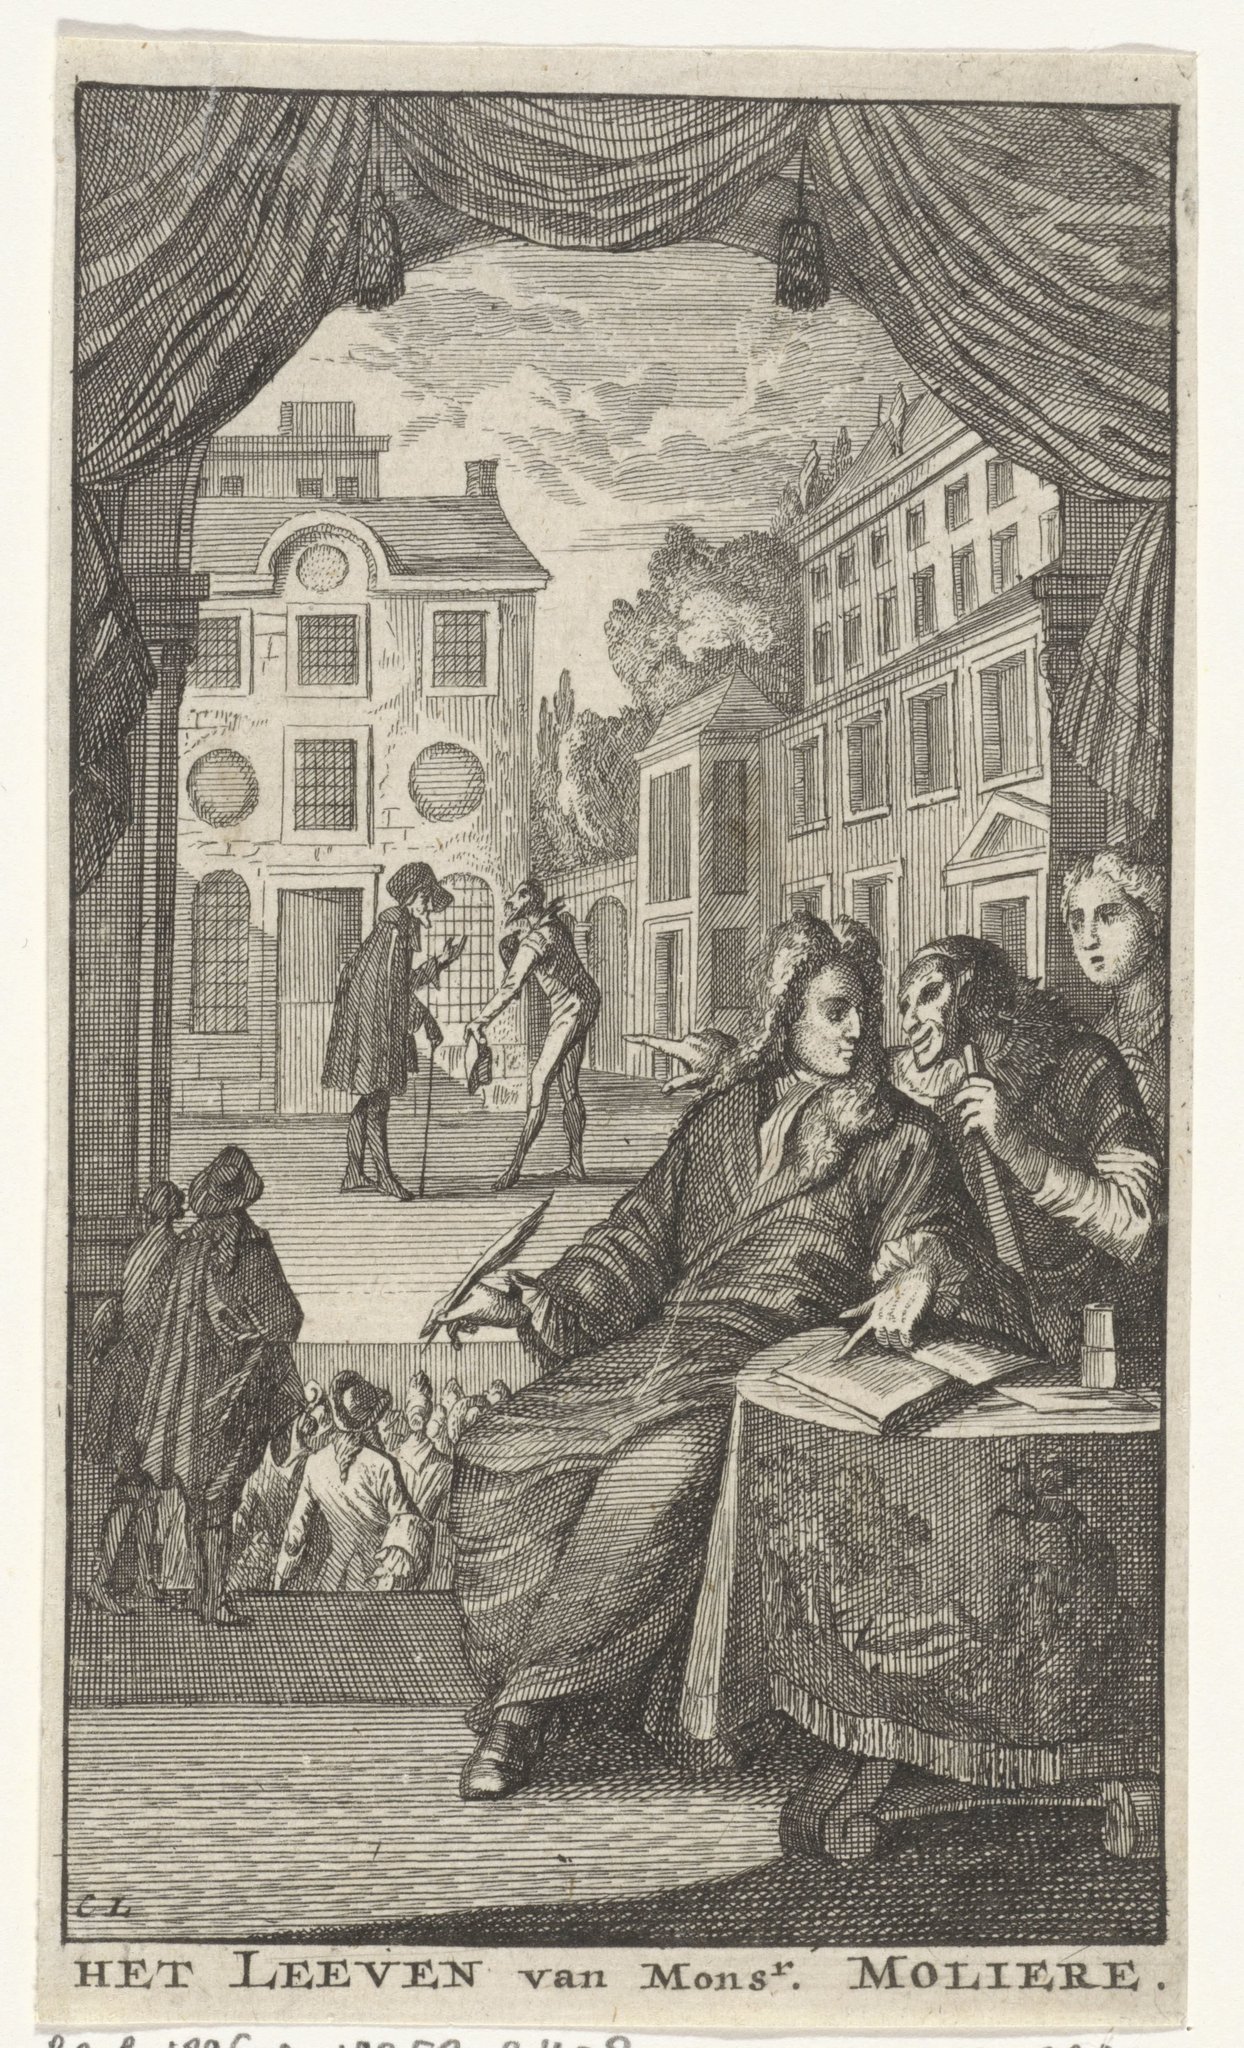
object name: print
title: Titelpagina voor: Het leven van Monsr. Moliere, 1705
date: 1705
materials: paper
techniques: etching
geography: amsterdam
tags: paris, jean baptiste poquelin molière, theatre, theatrical performance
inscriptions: collector's mark: Lugt 2228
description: Op de voorgrond wordt Jean Baptiste Poquelin Molière tijdens het schrijven gestoord door een gemaskerde man. Op de achtergrond wordt een toneelvoorstelling opgevoerd.